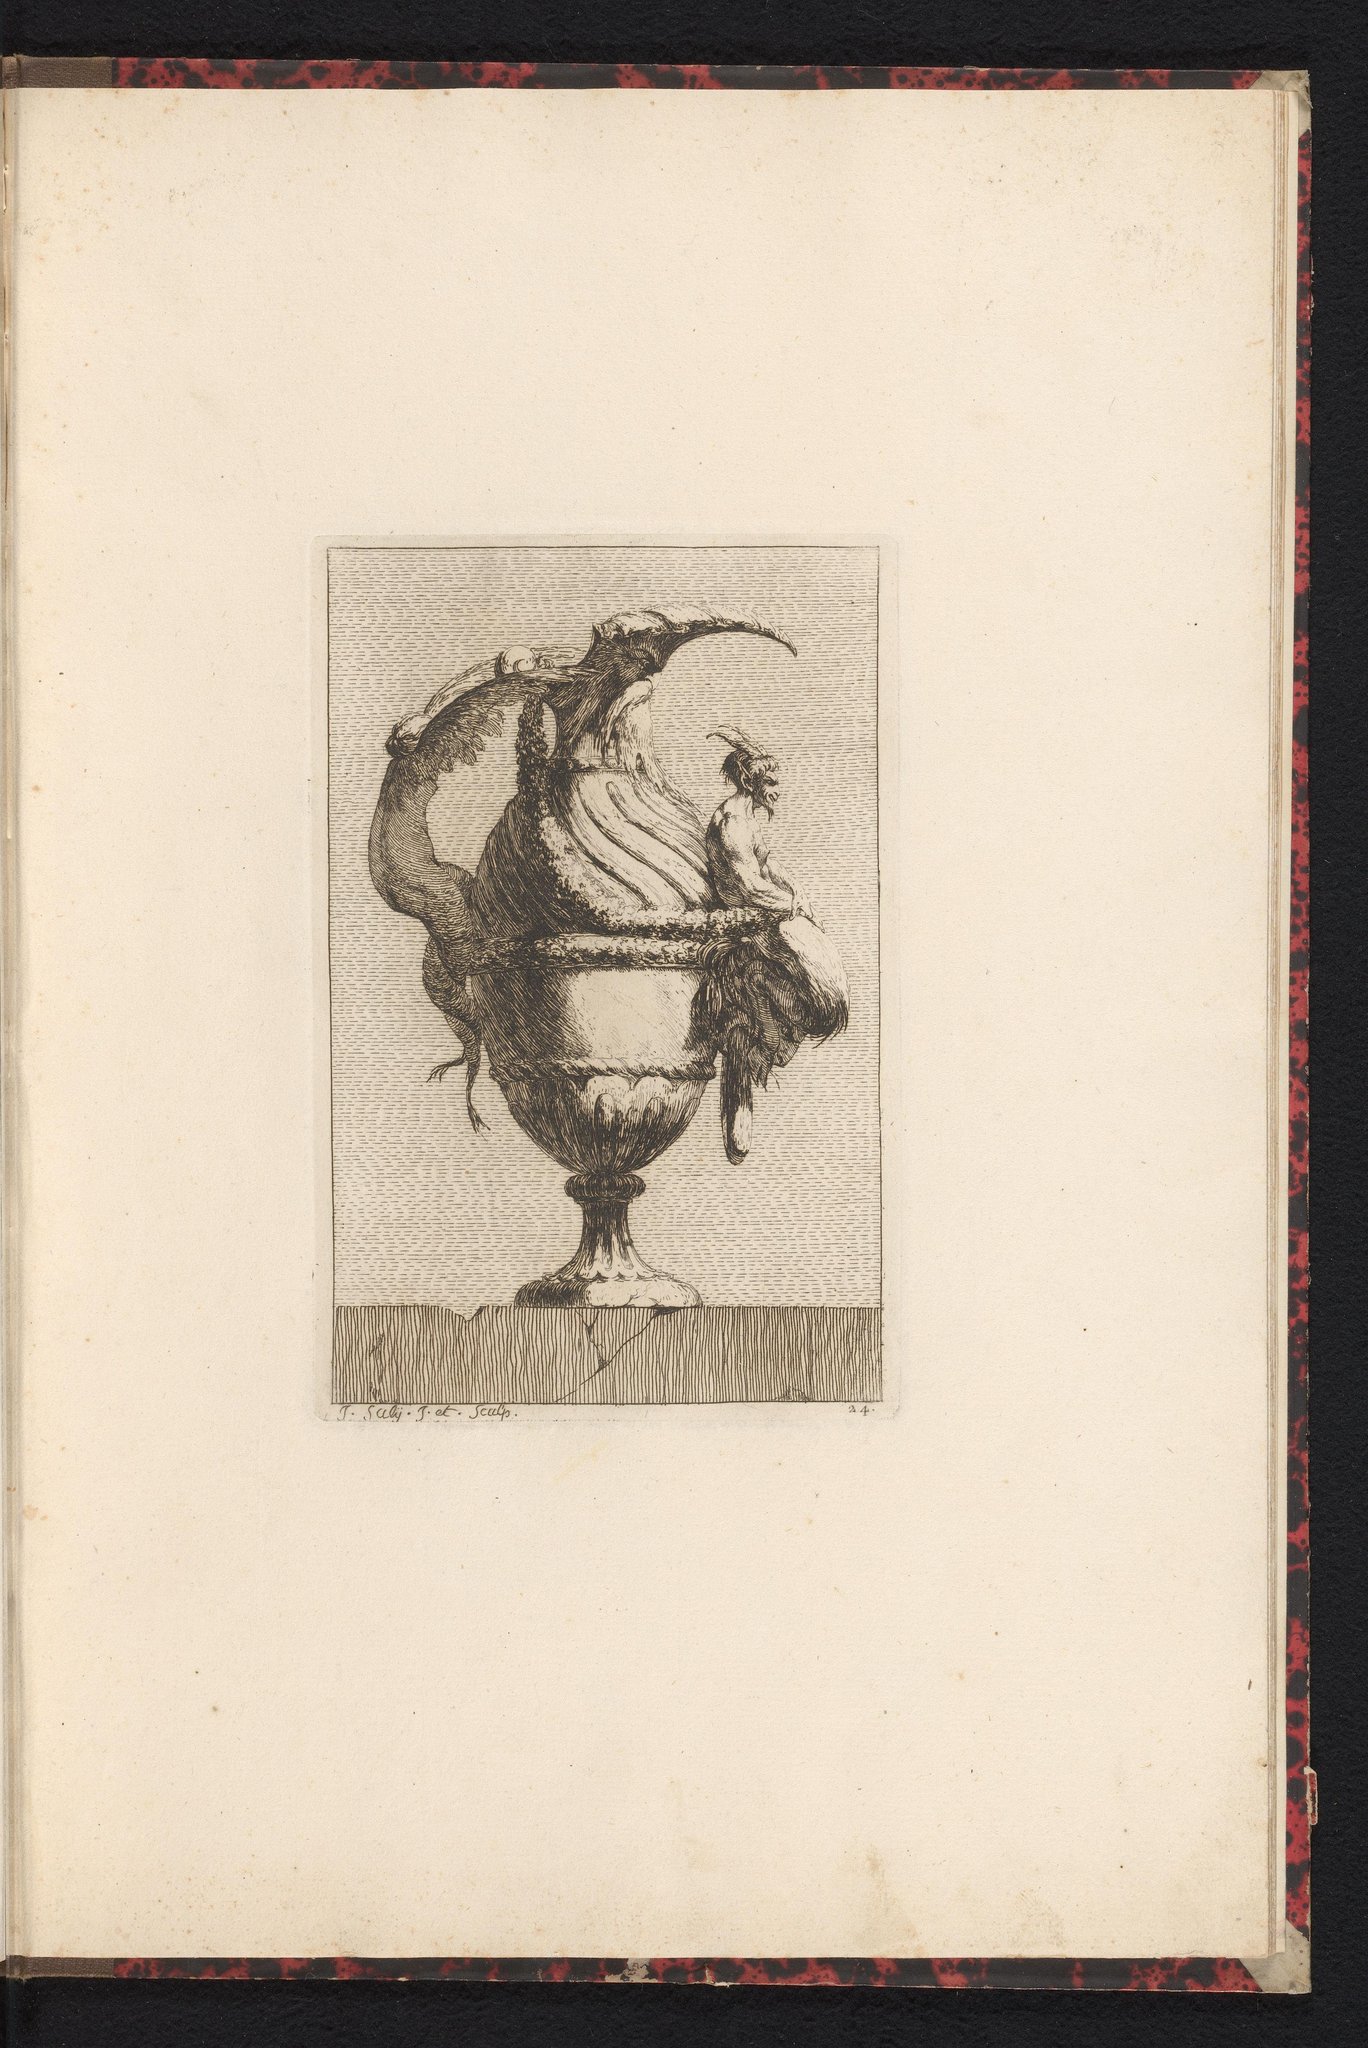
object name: ornament print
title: Kan met een oor in de vorm van een meermin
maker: jacques francois joseph saly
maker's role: print maker, sculptor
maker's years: 1717-1776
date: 1746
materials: paper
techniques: etching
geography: france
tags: tales and fairy tales (with title), satyr(s) (in general), mask, mascaron ~ ornament, garden vase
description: De meermin is gevleugeld. Ook de gespleten staart van deze figuur suggereert dat het hier mogelijk om Melusine gaat. De schenktuit van de kan is een mascaron. Daaronder een satyr boven een masker. Deze prent maakt deel uit van een album.